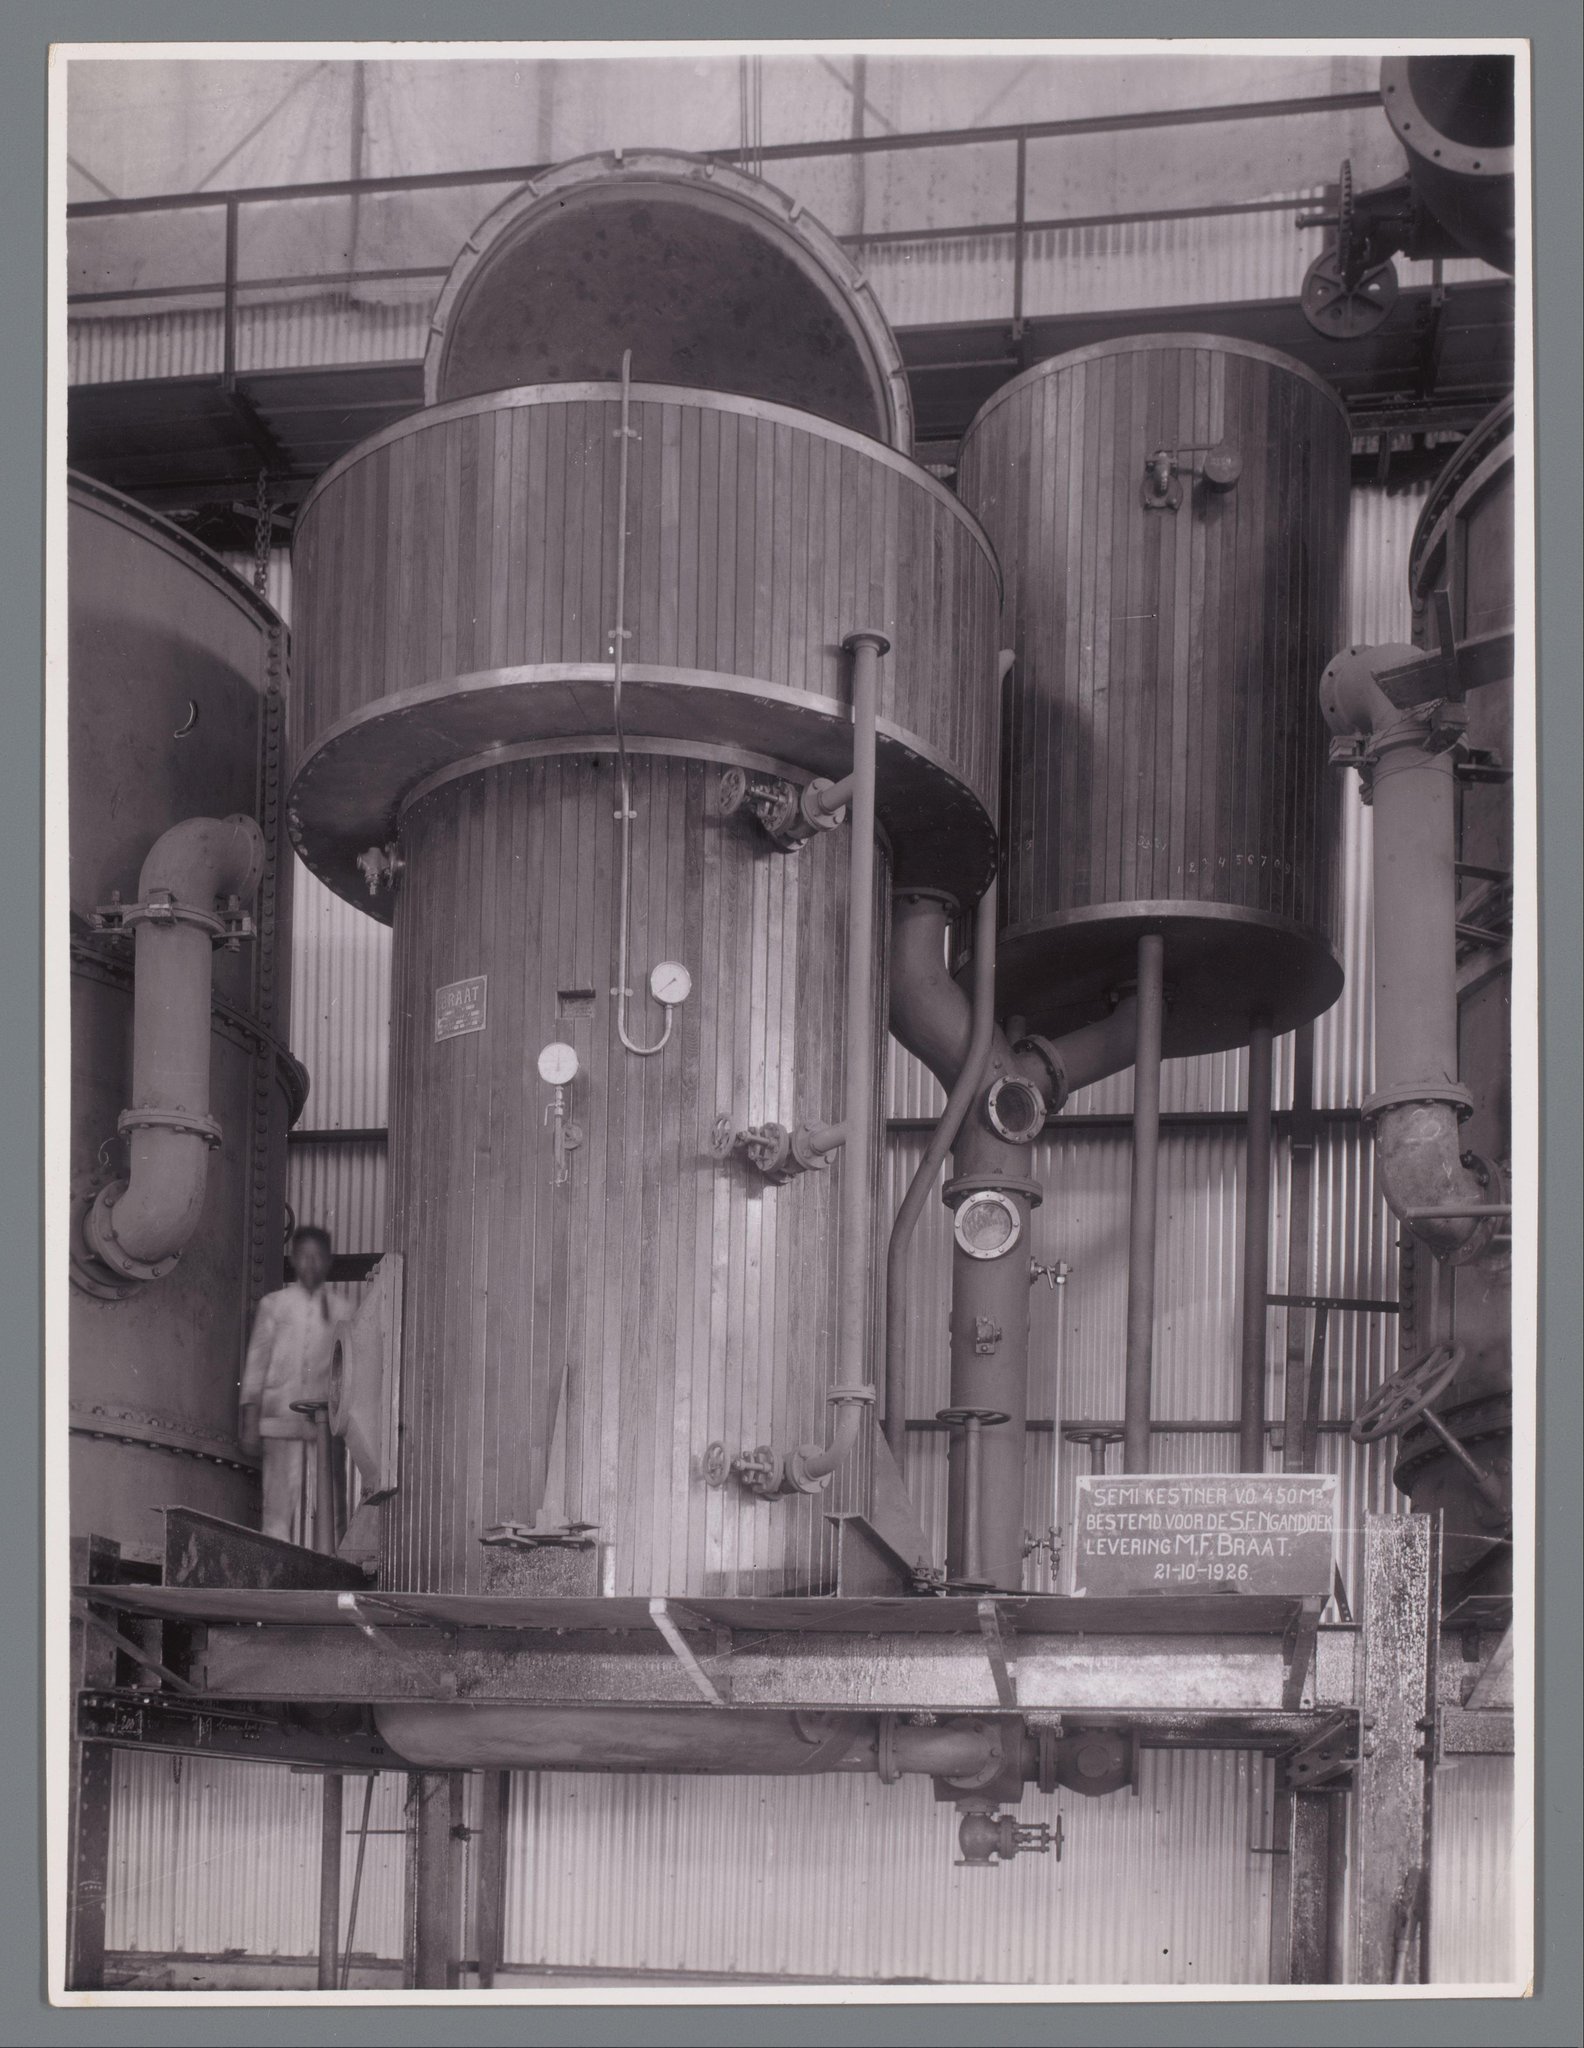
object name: photograph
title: Semi kestner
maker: Anonymous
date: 1926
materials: photographic support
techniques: gelatin silver print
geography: surabaya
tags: colonial system, factory-interior, machine shop, machines; parts of machines; tools and appliances, (non-fruit) products of plants or trees: sugarcane, java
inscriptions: date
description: Semi kestner vervaardigd in 1926 en bestemd voor de Suikerfabriek Ngandjoek. Onderdeel van de multomap met foto's van machines van de N.V. Machinefabriek Braat te Soerabaja bestemd voor de Nederlandse suikerindustrie op Java, uit de periode 1917-1938.